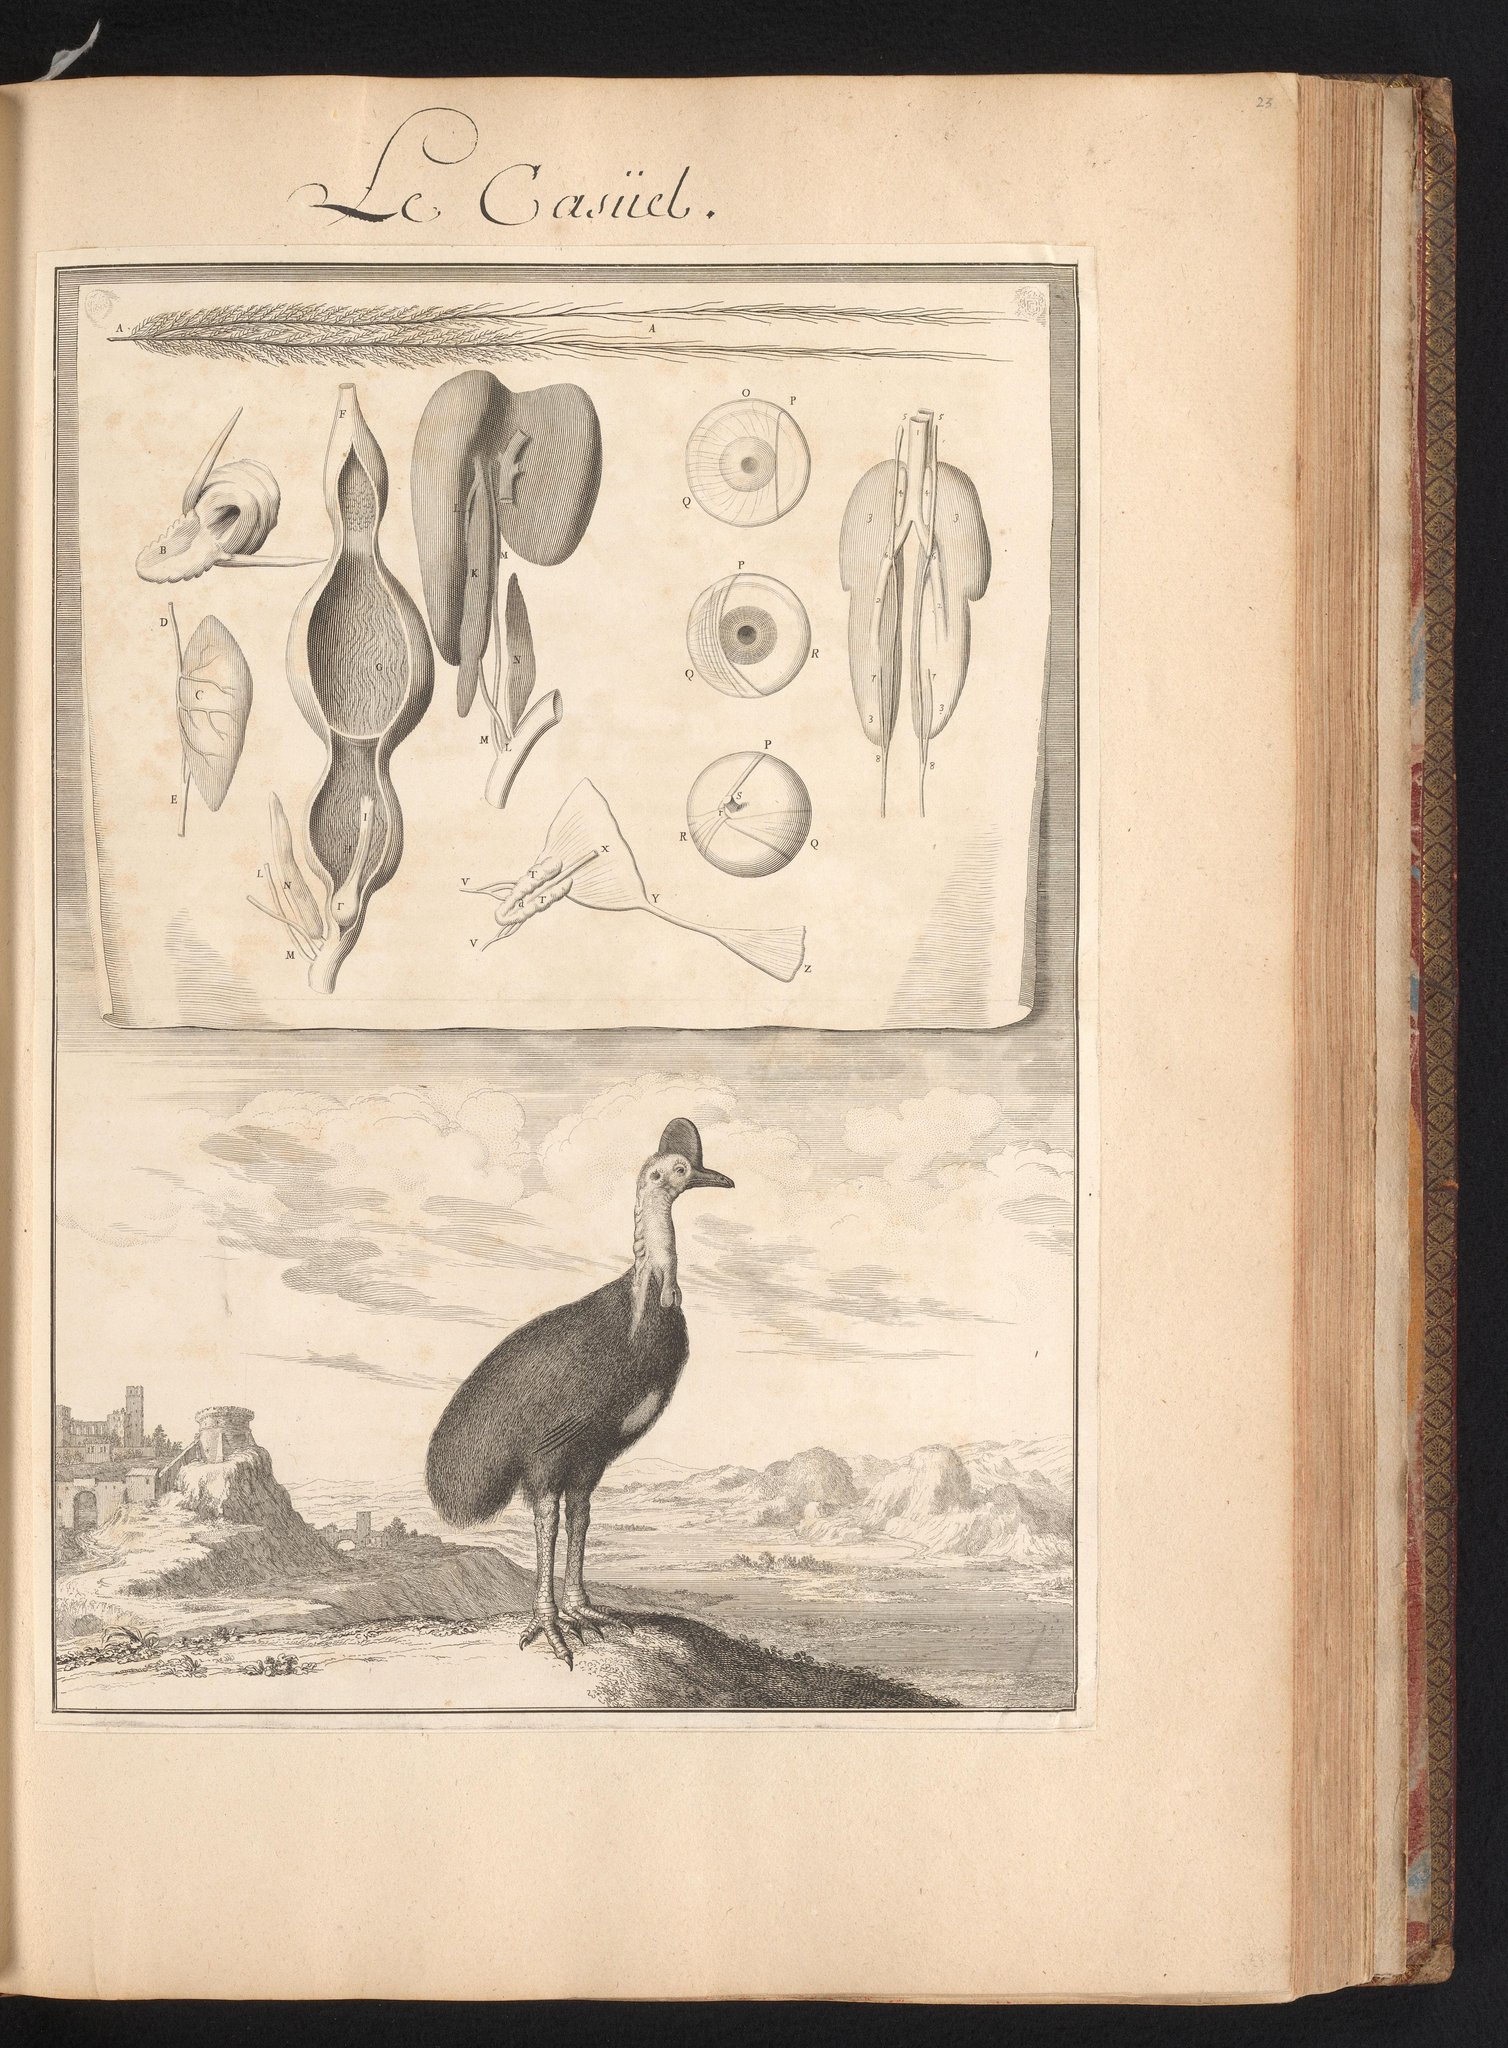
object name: album leaf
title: Helmkasuaris (casuarius casuarius) in een landschap met bovenaan op een blad de organen en veren van het dier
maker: sébastien leclerc (i)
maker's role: print maker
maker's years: 1637-1714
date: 1676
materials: ink, paper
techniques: engraving, etching, pen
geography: paris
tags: dissection, walker and runner birds, animals (+ anatomy of animals)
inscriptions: inscription: ‘Le Casüel.’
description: Prent uit: Perrault, Claude. Mémoires pour servir à l'histoire naturelle des animaux. Dressez par M. Perrault de l'Académie Royale des Sciences (...). Parijs: Imprimerie Royale, 1676.